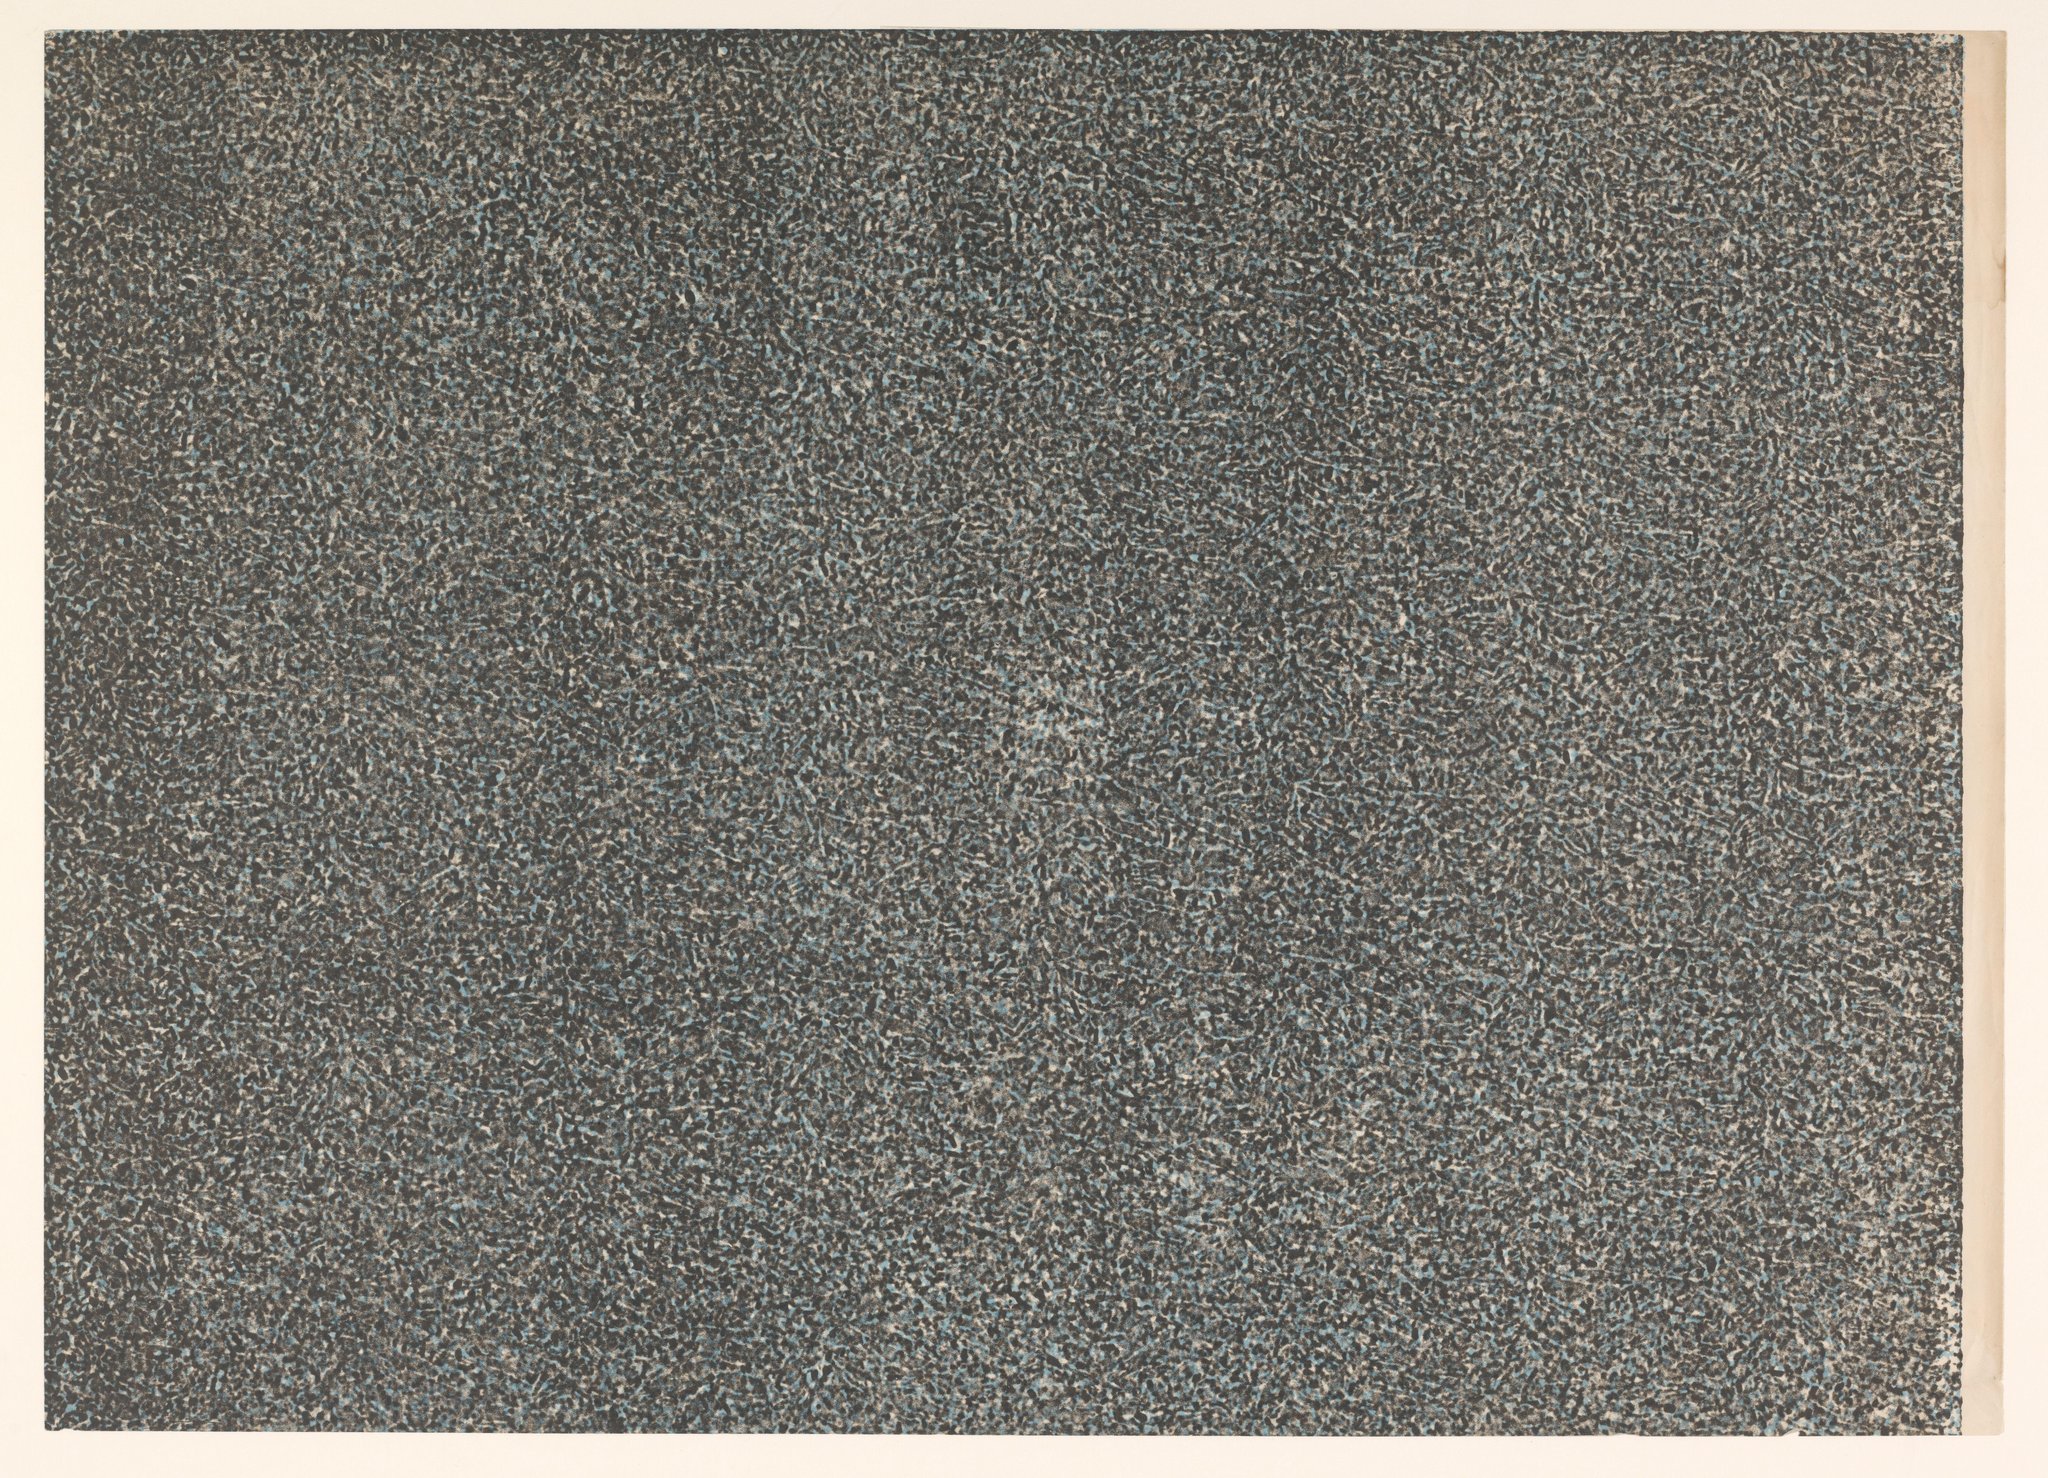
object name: decorated paper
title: Gevlekt patroon in lichtblauw met zwart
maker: Anonymous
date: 1880-1950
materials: ink, paper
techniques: lithograph